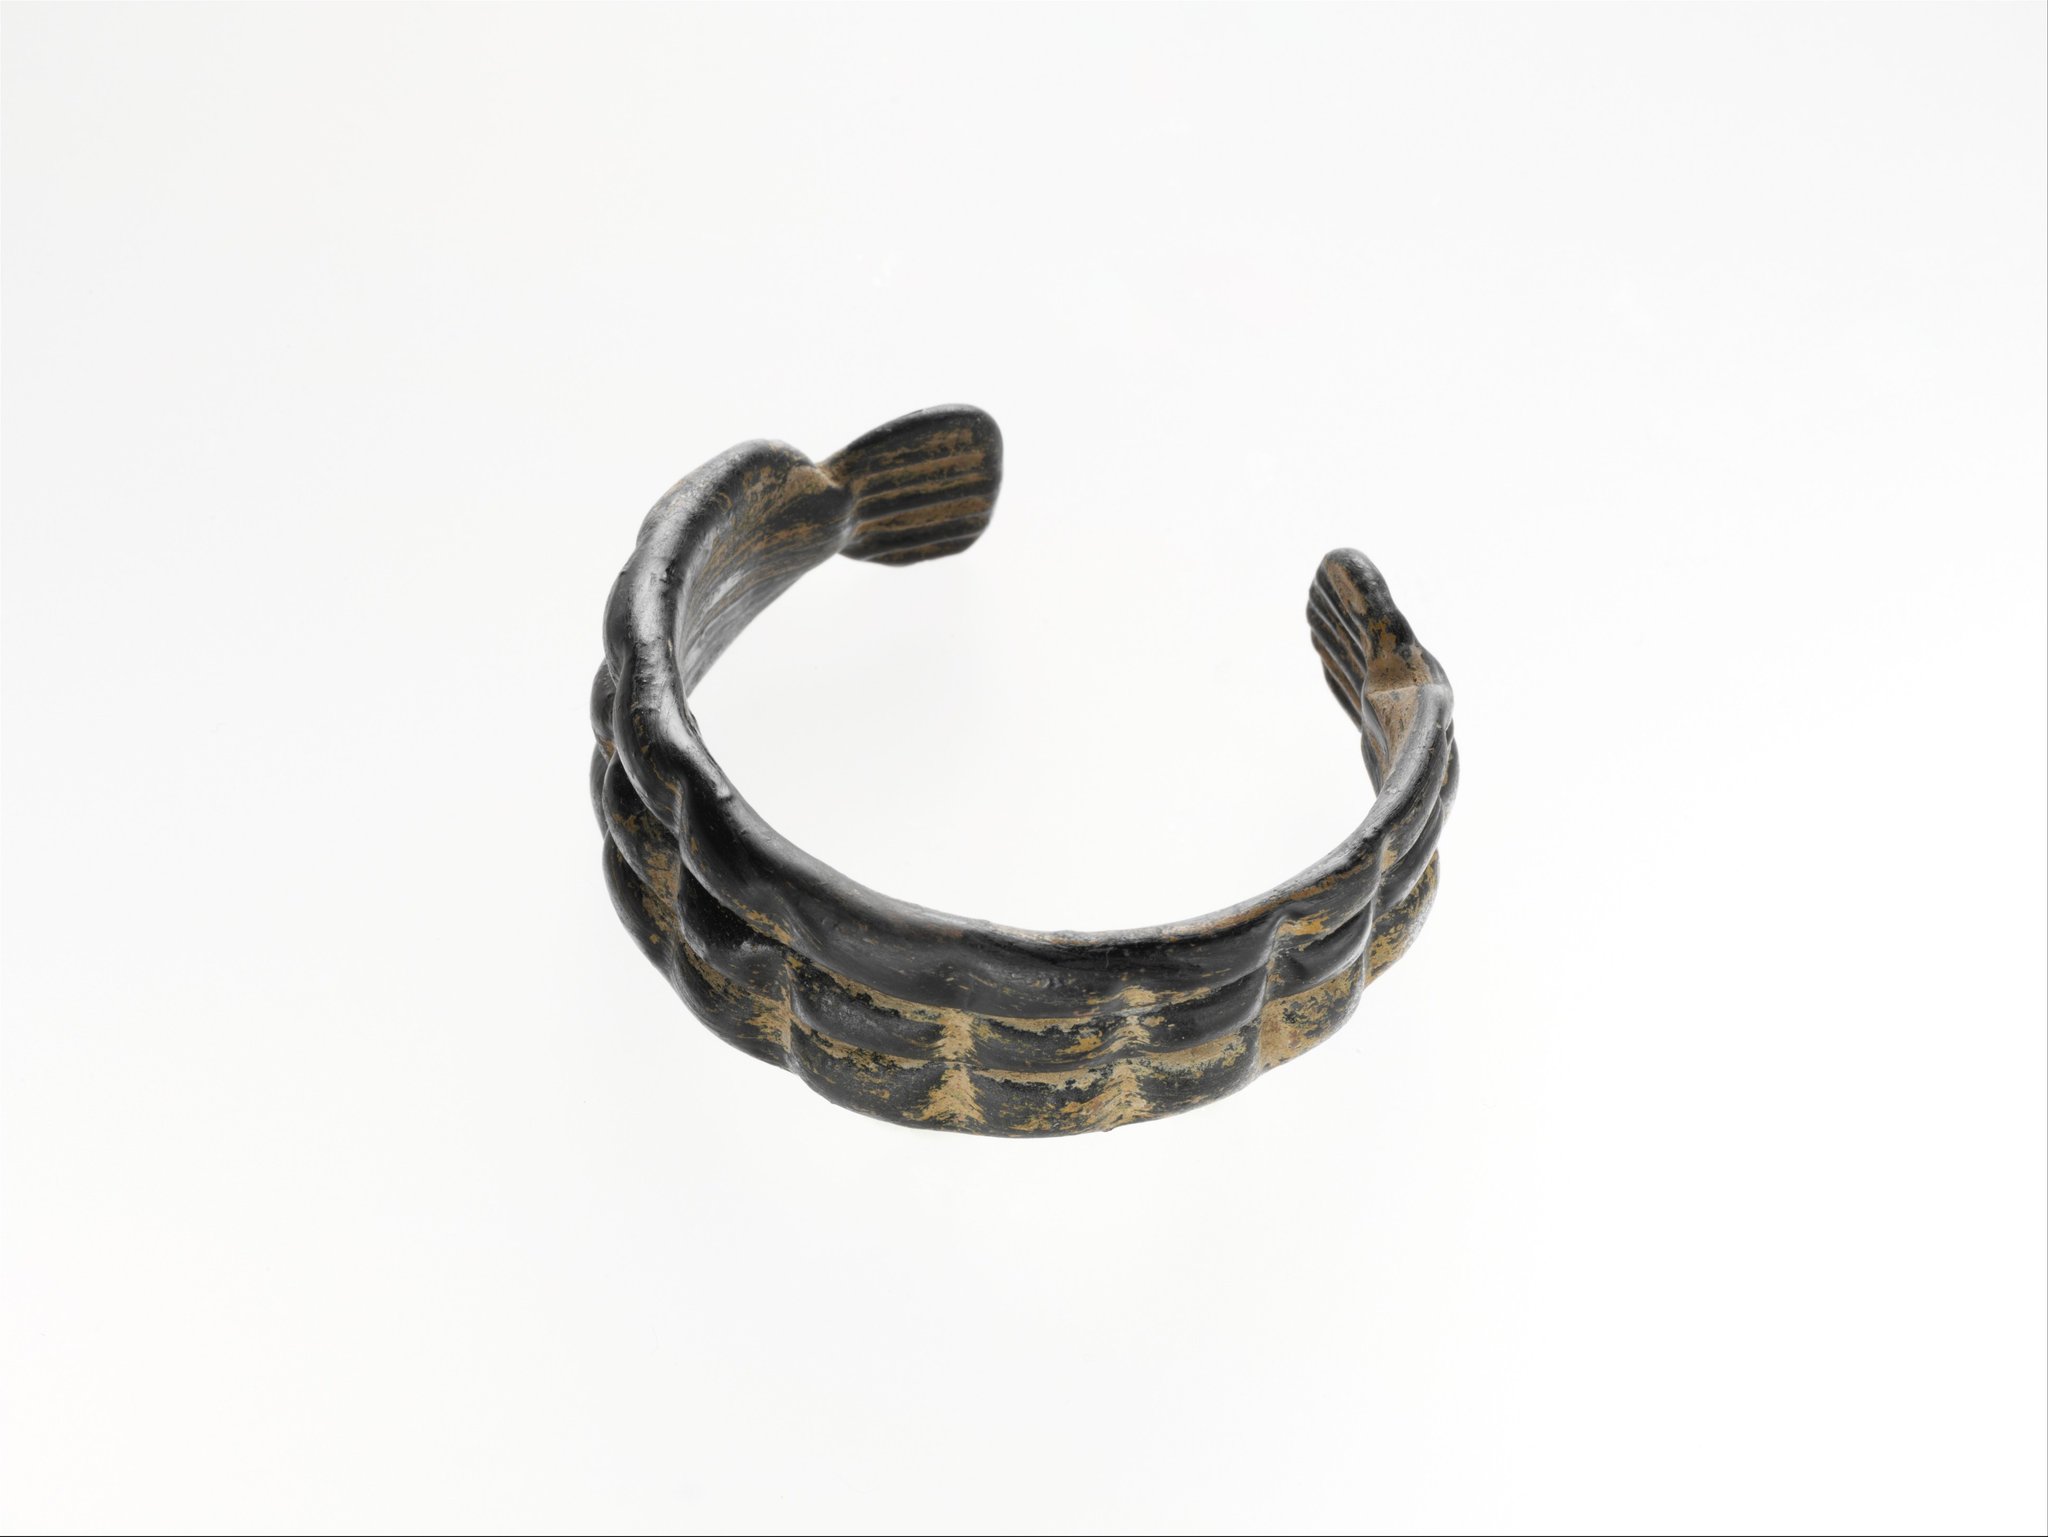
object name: bracelet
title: Glass bracelet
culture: roman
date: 301-500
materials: glass